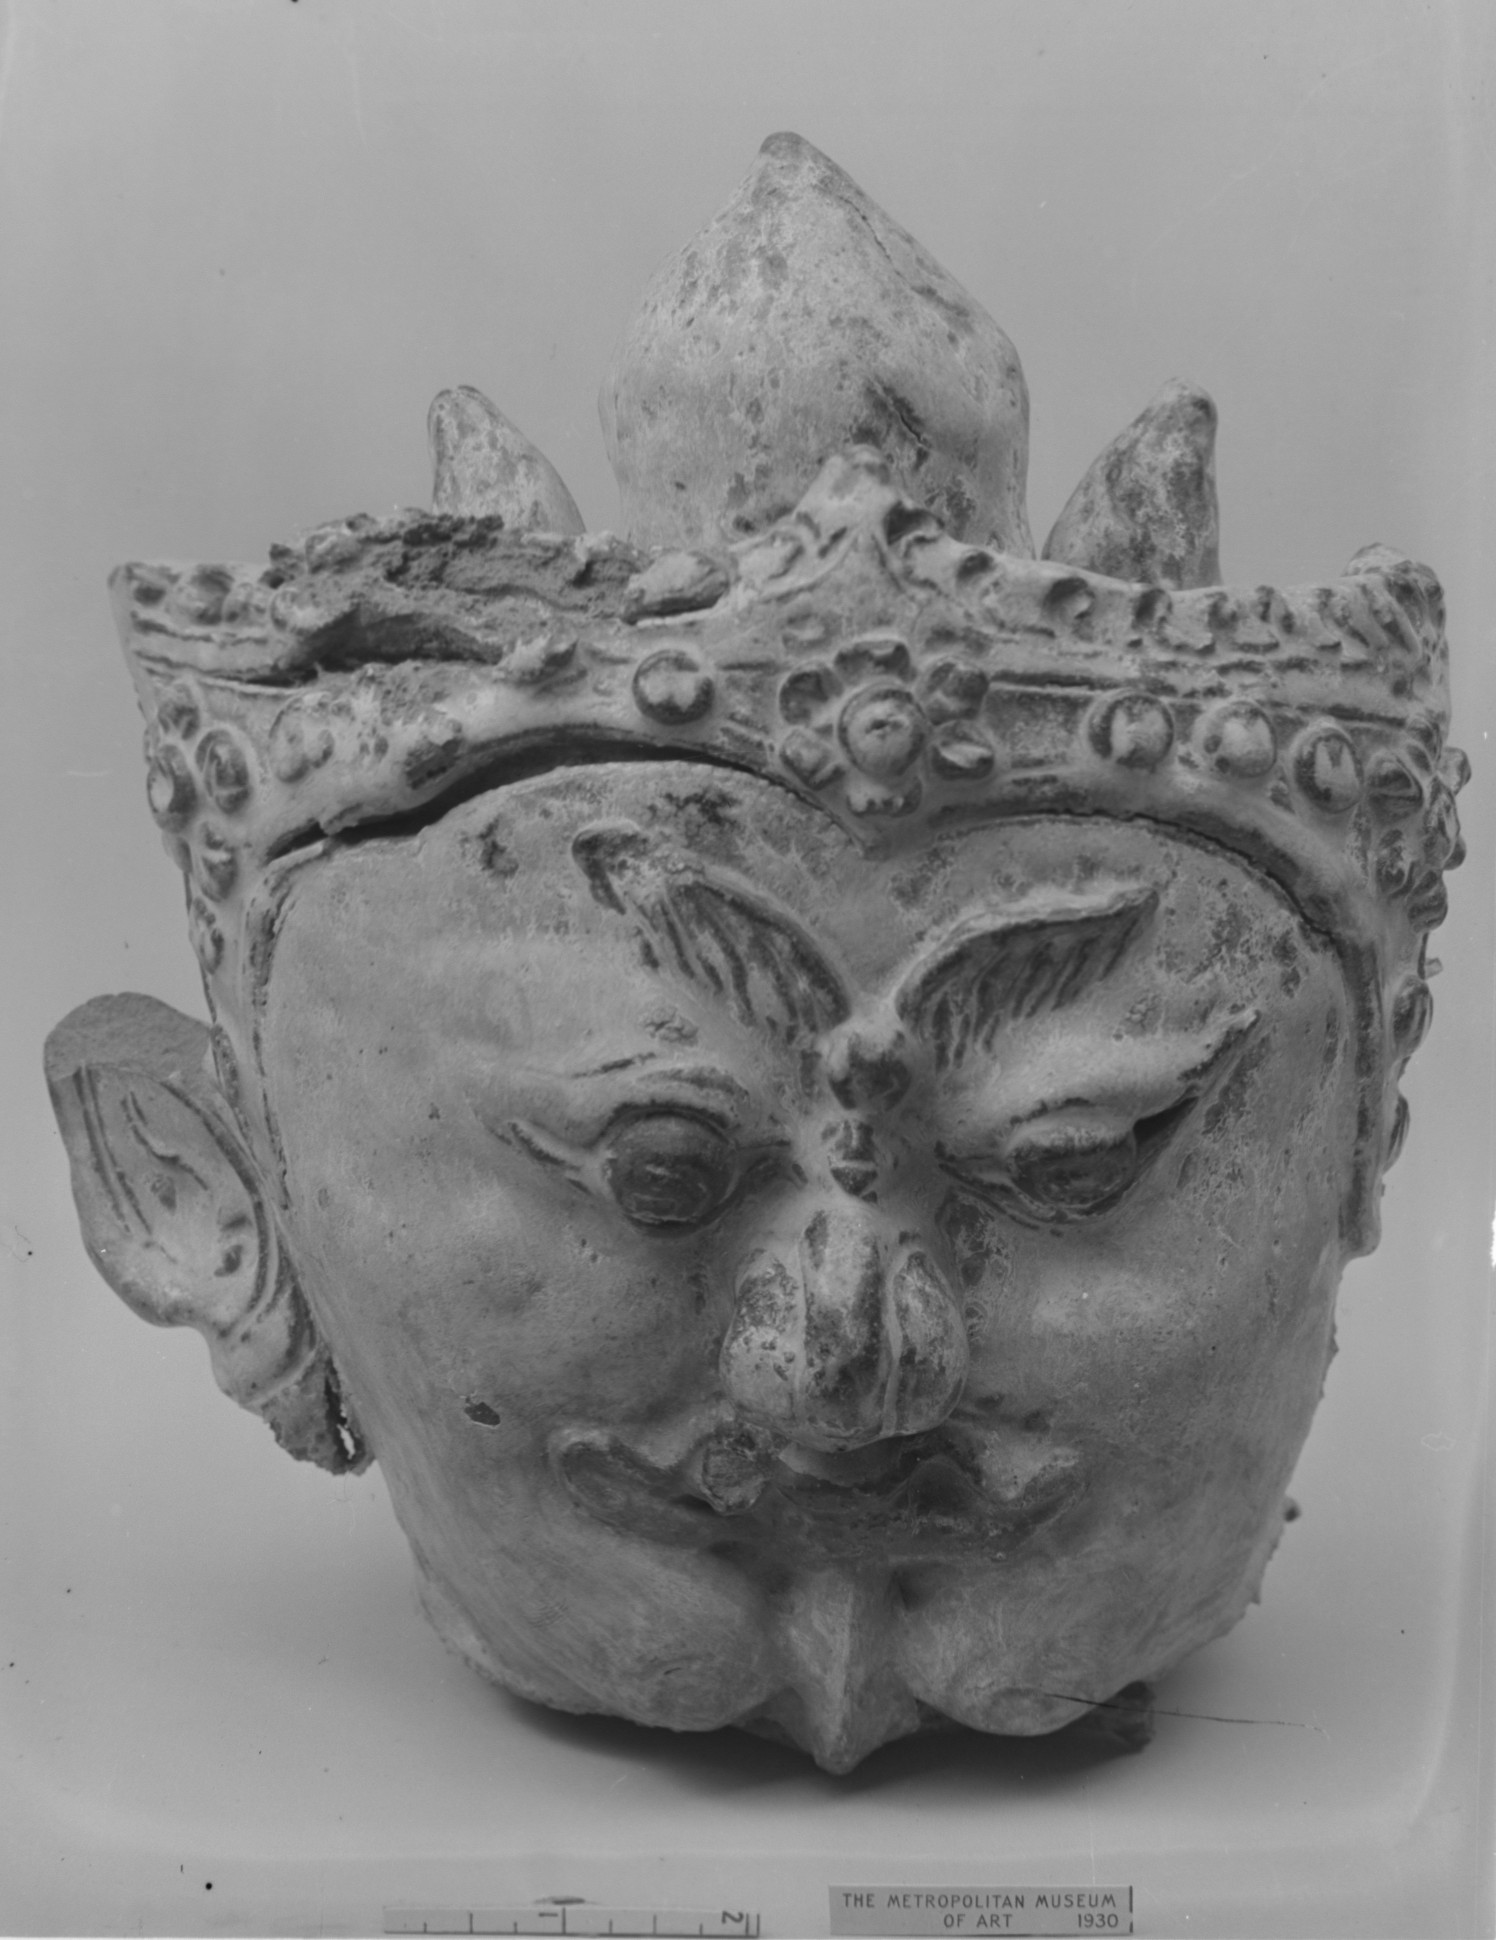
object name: head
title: Head of a Giant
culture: thai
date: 1301-1500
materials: ceramic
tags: heads,men